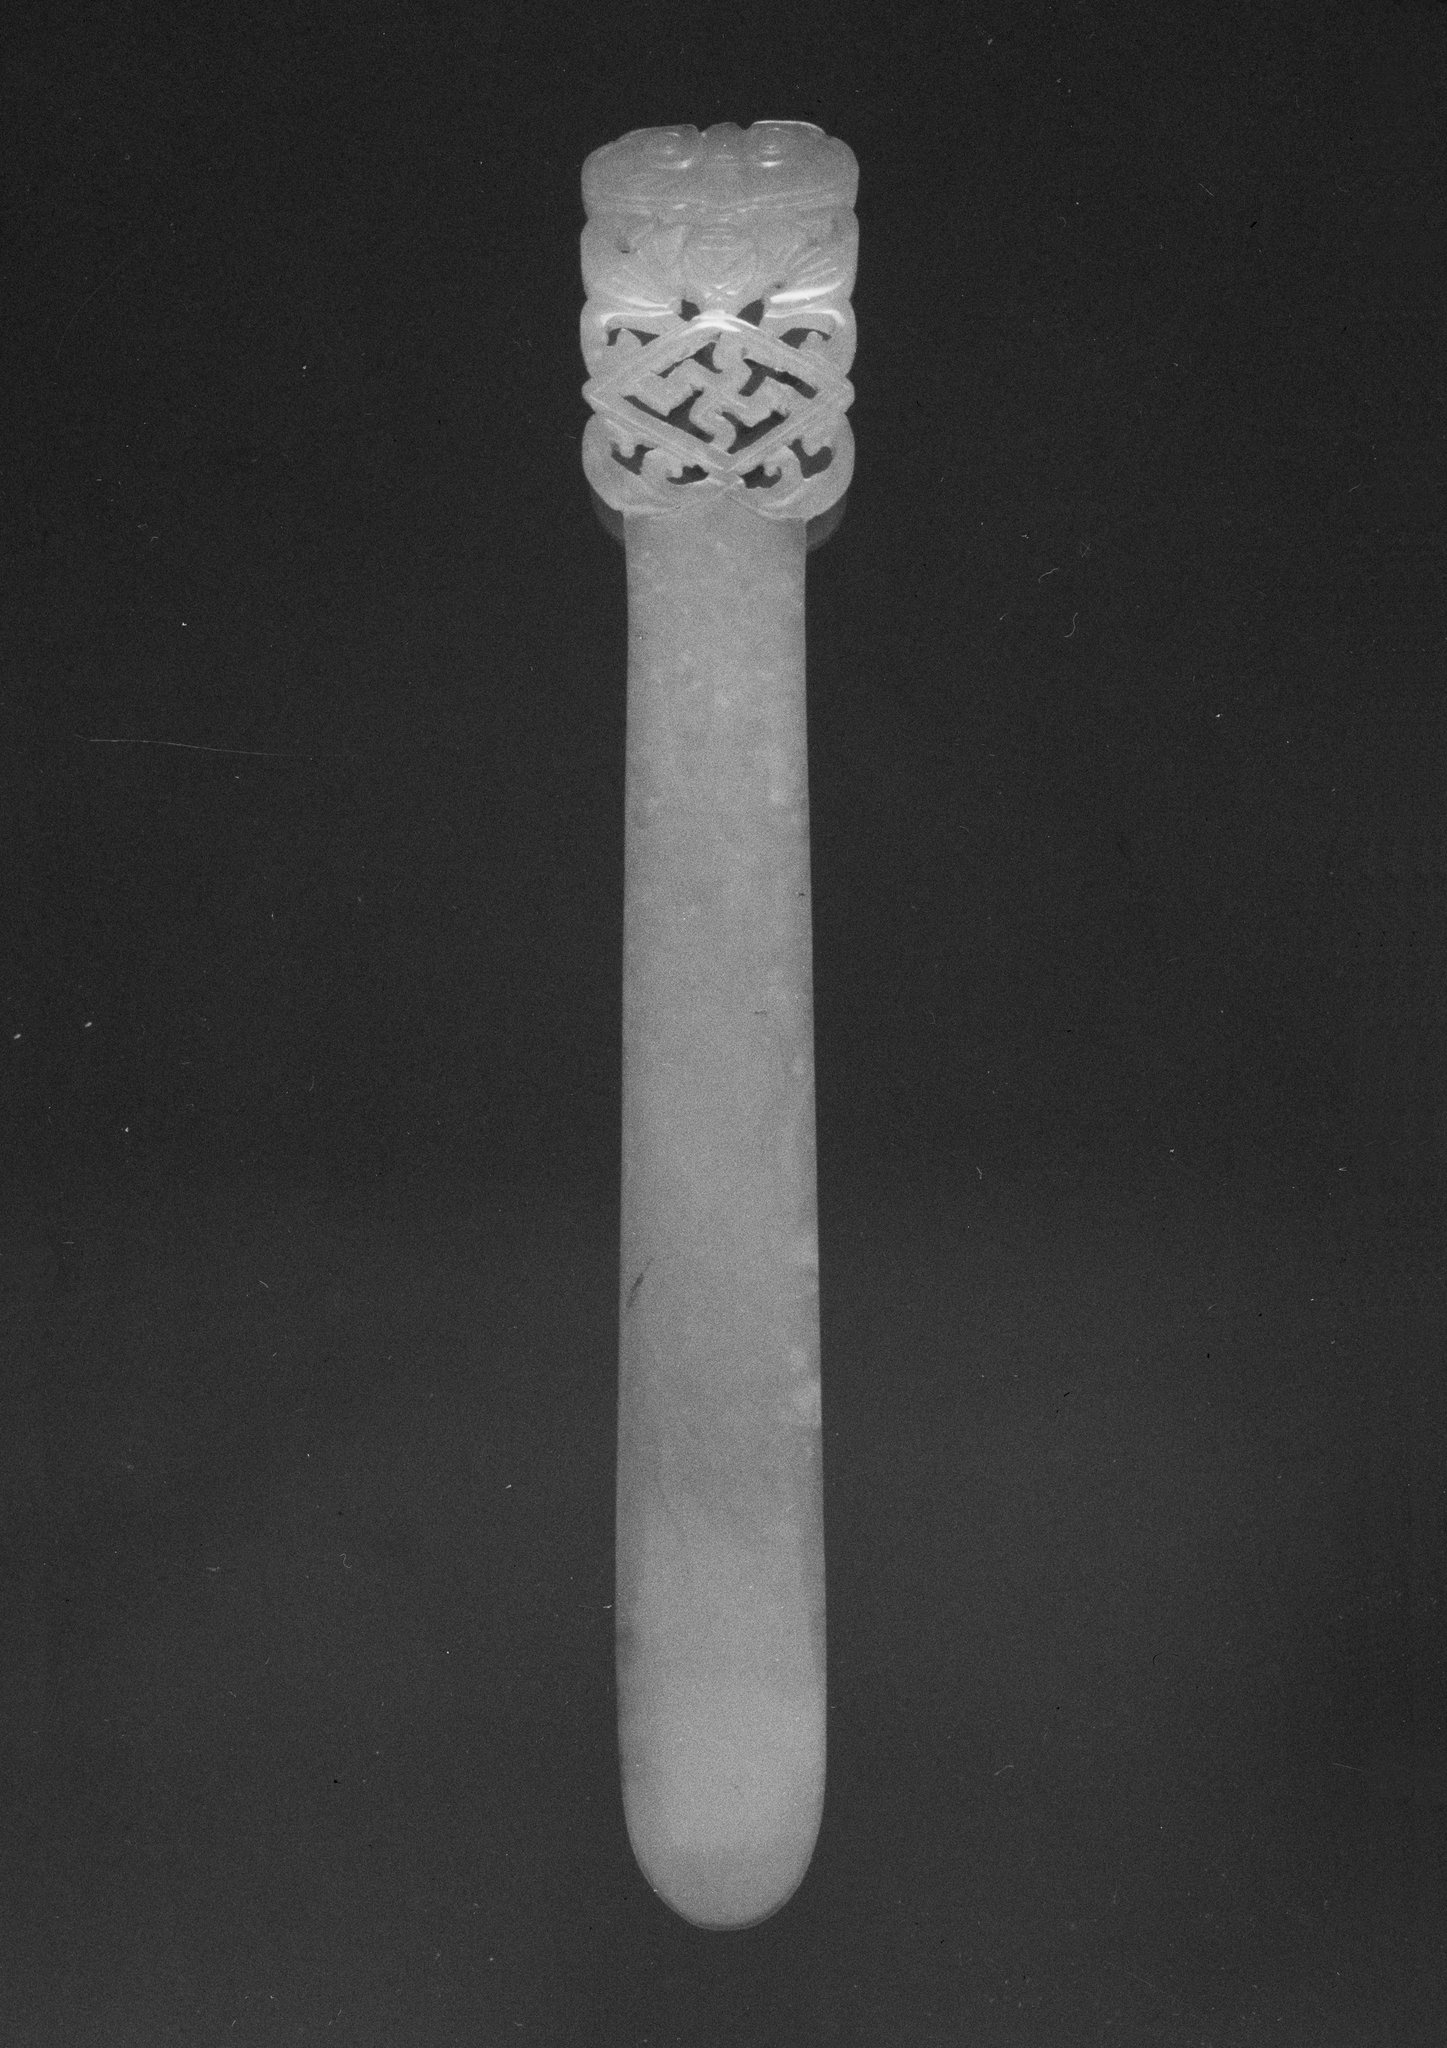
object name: hairpin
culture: chinese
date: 1801-1900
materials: jade